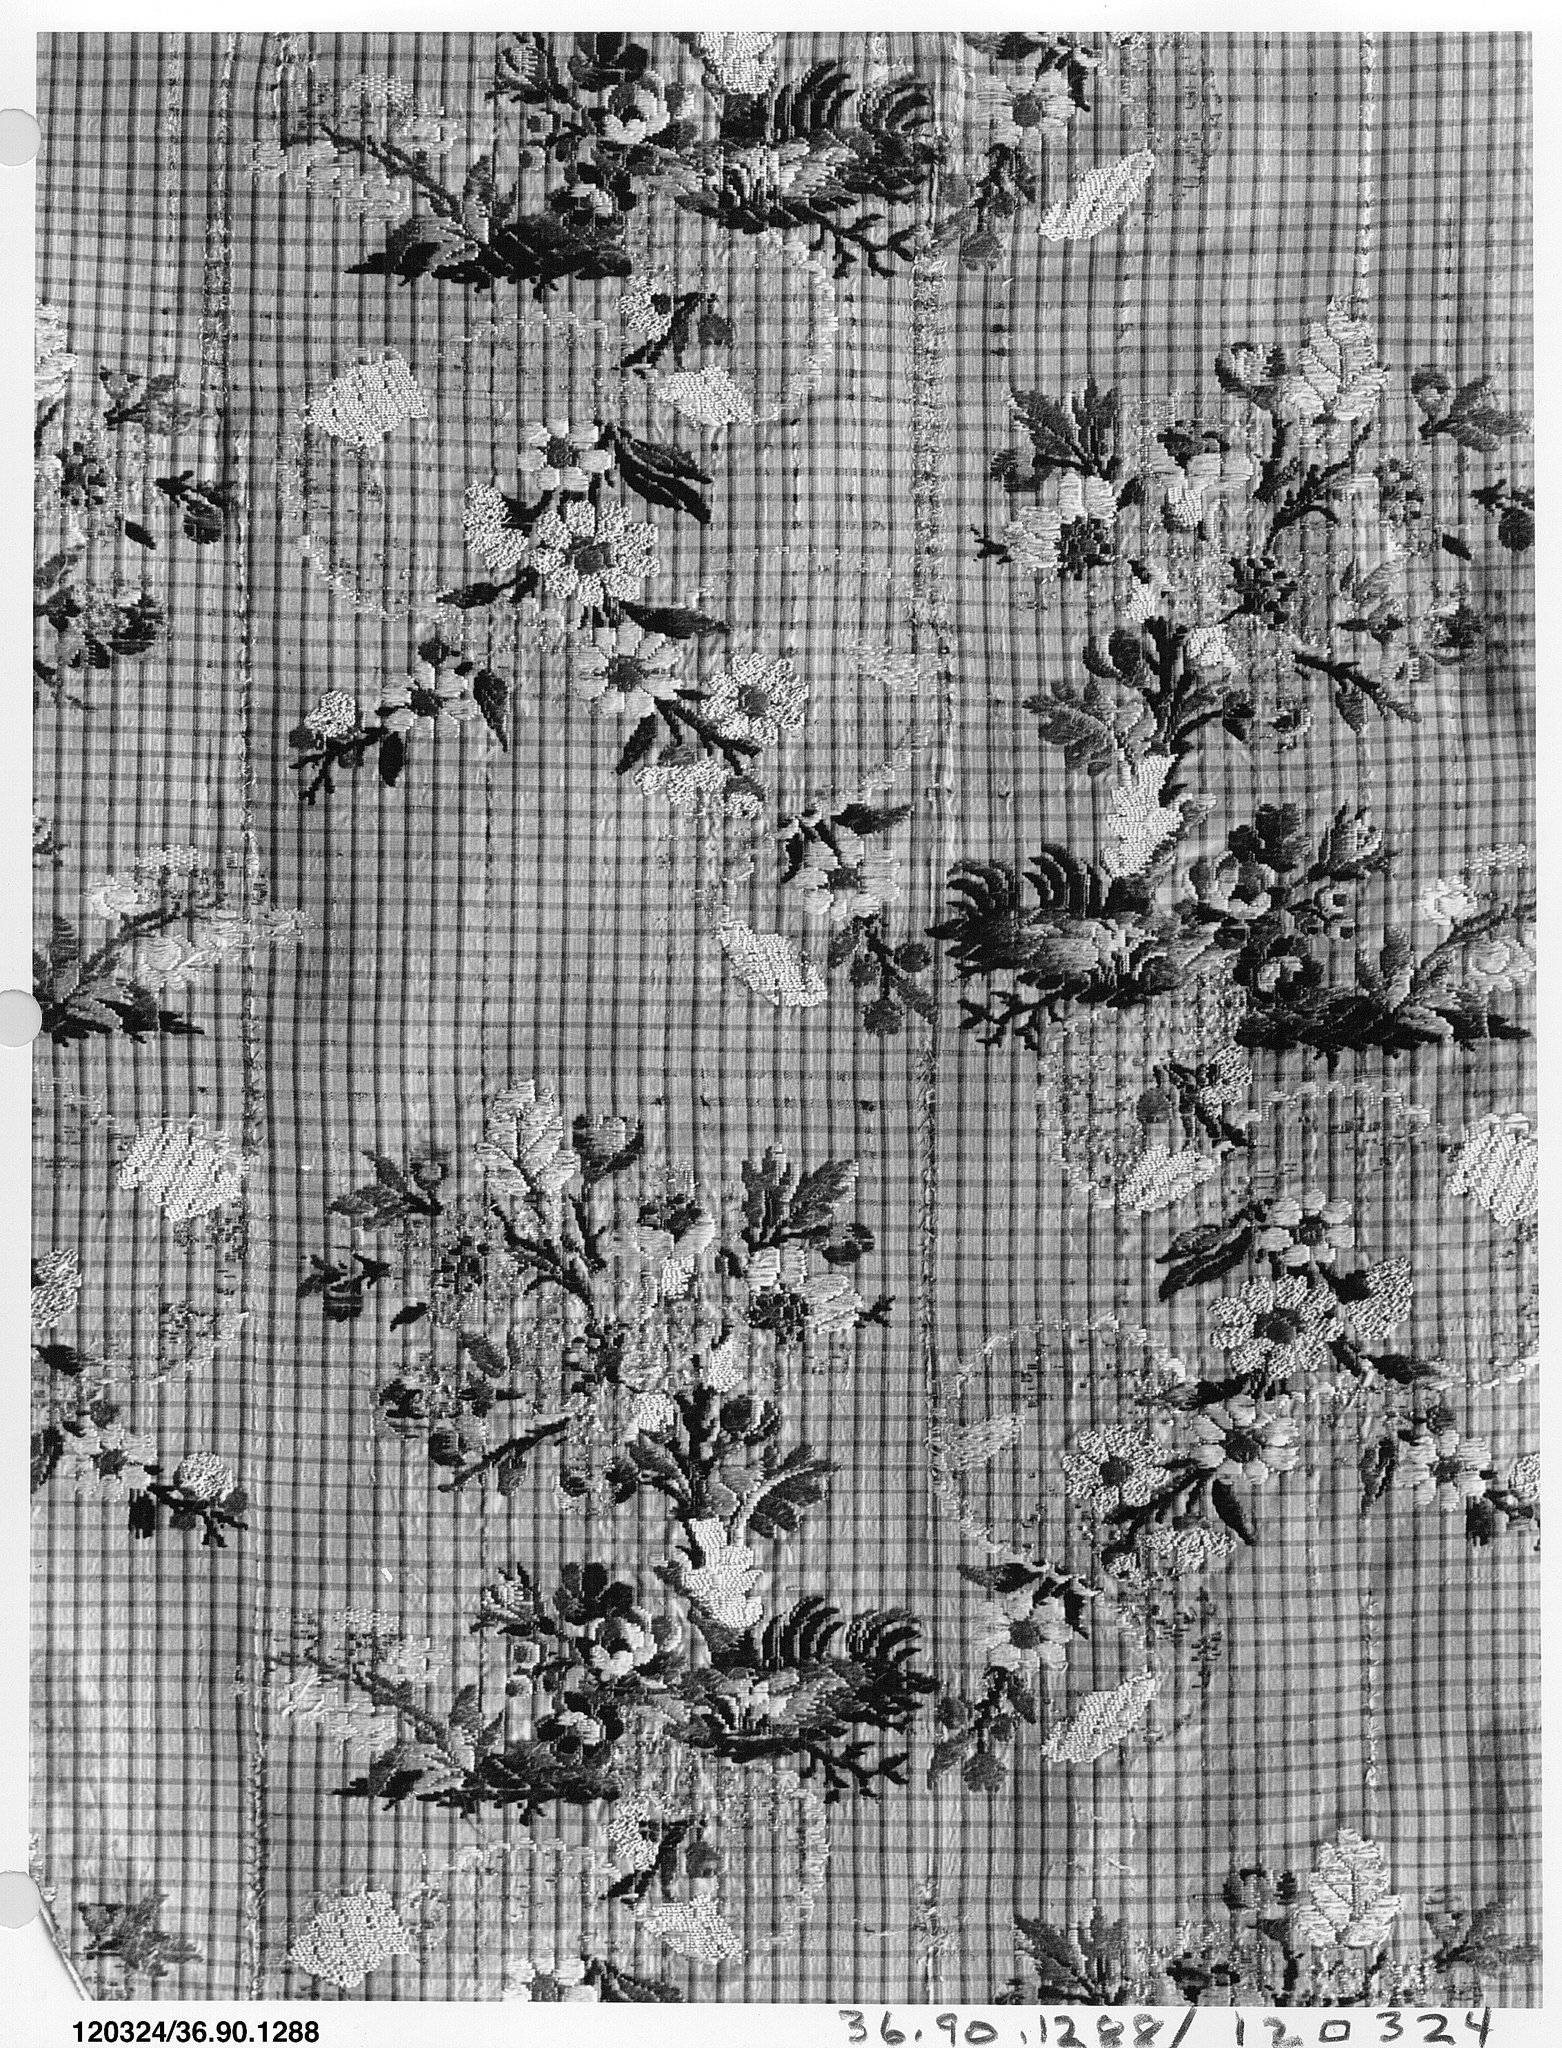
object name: piece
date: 1750-1760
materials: metal thread, silk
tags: flowers,leaves